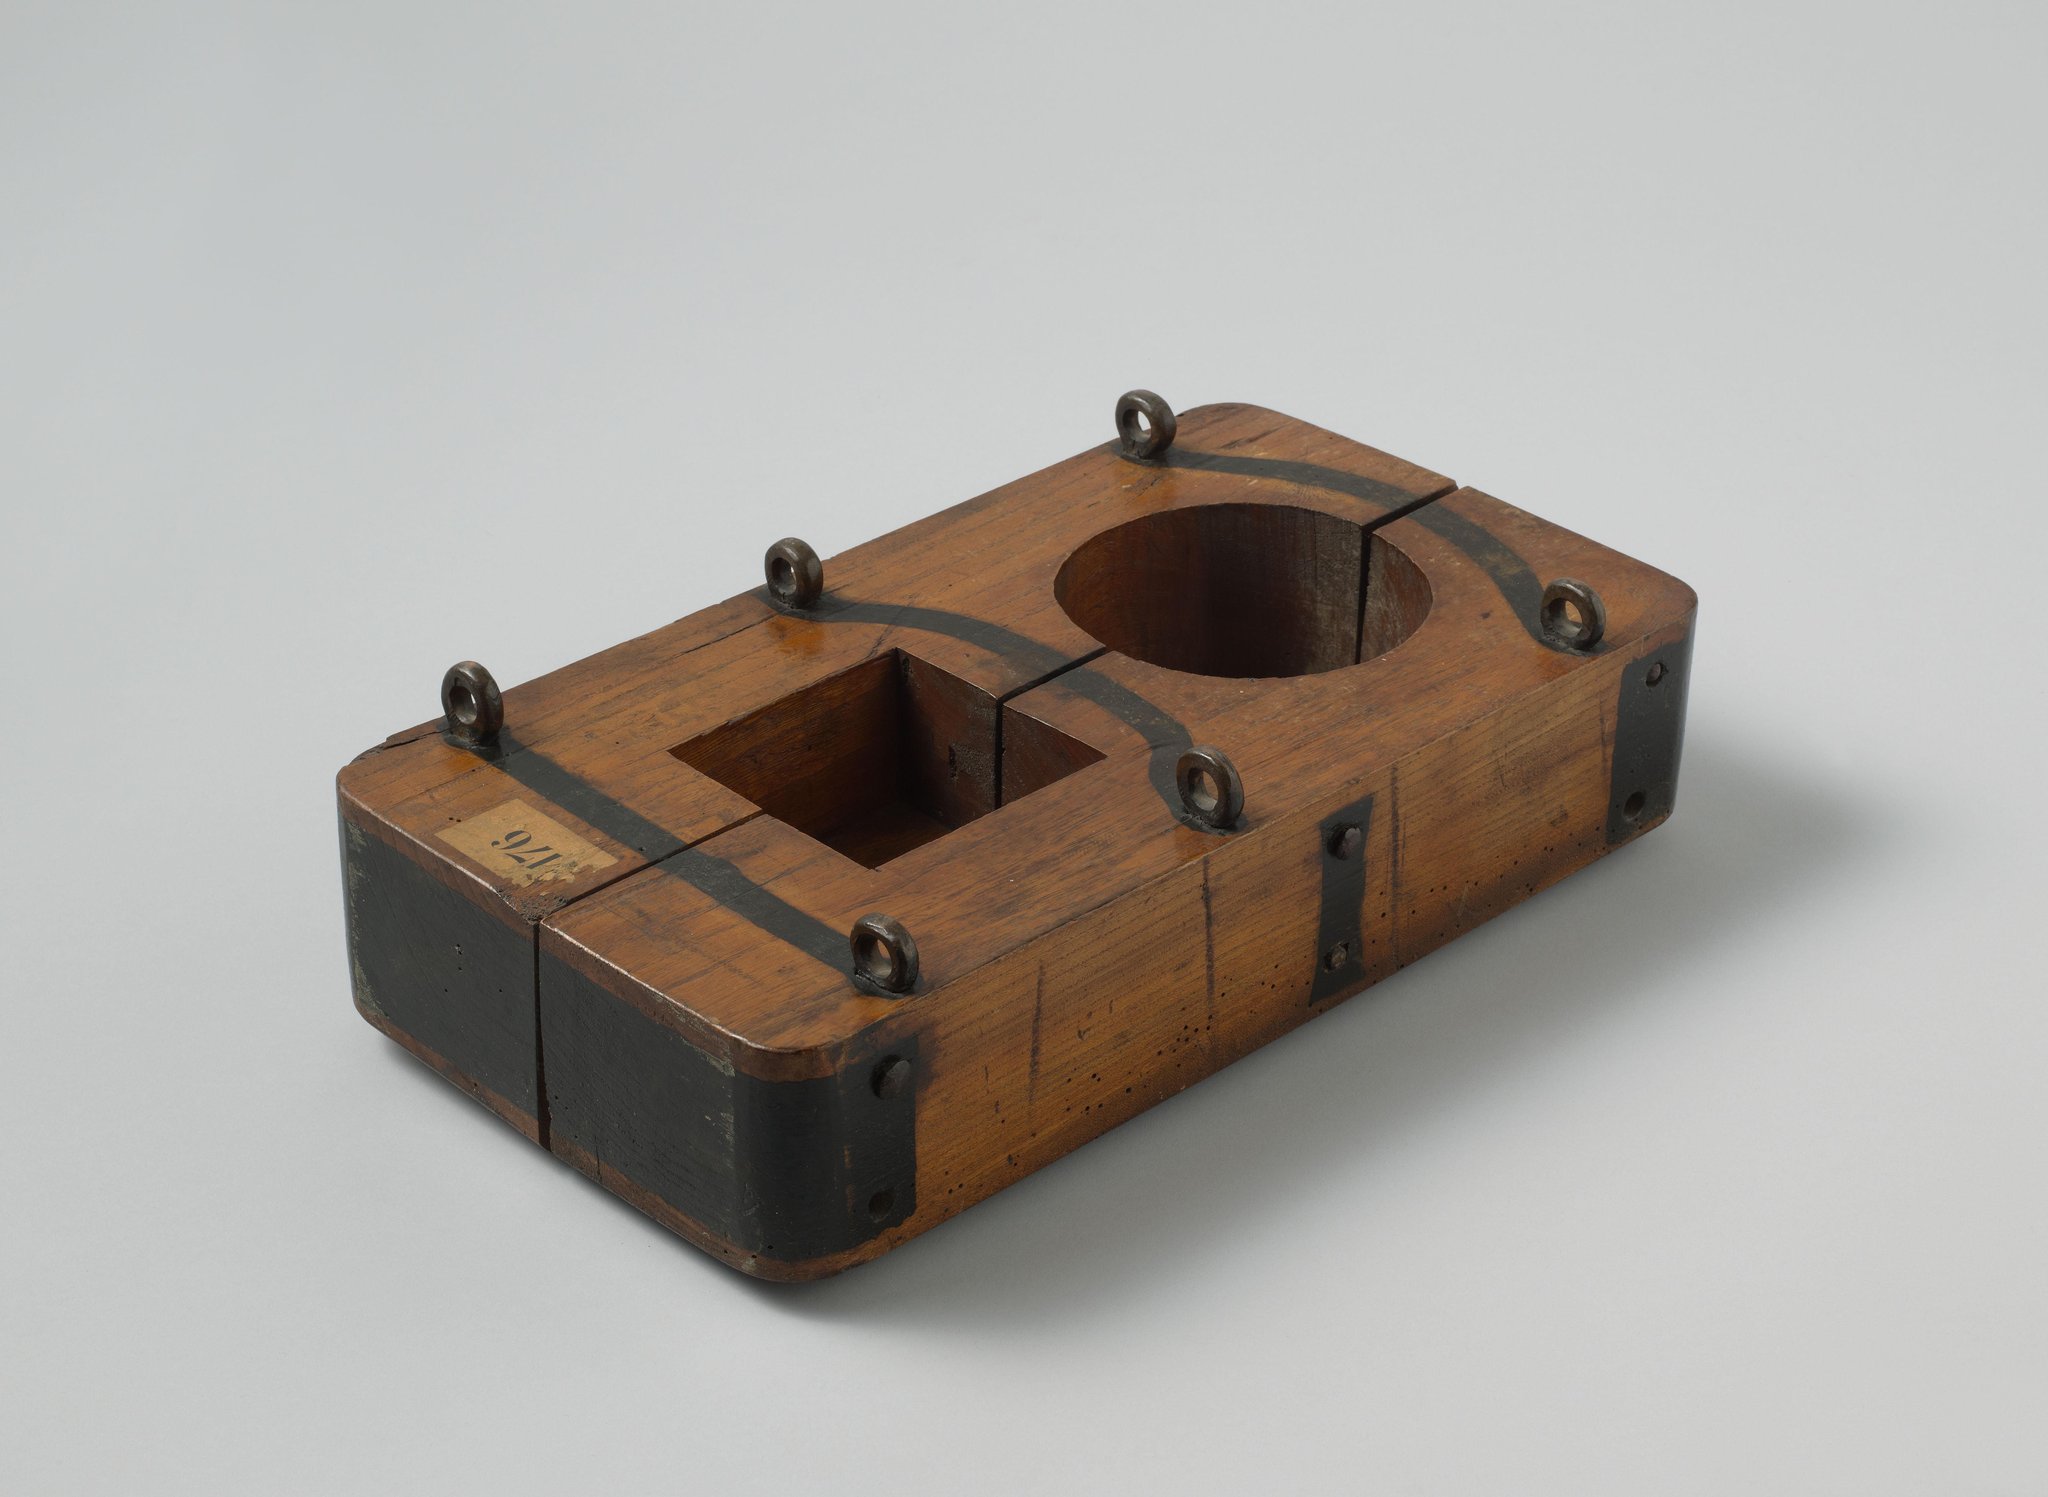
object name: demonstration model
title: Model of a Mast Cap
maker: Anonymous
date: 1780-1840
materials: iron, paint, wood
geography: netherlands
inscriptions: label, top centre: ‘176’ former inventory label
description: Model van een rechthoekig ezelshoofd voor een mast met vierkante top, bestaande uit twee helften met zes klinkbouten bijeengehouden. Onderop zes ogen. Het overige beslag is opgeschilderd.